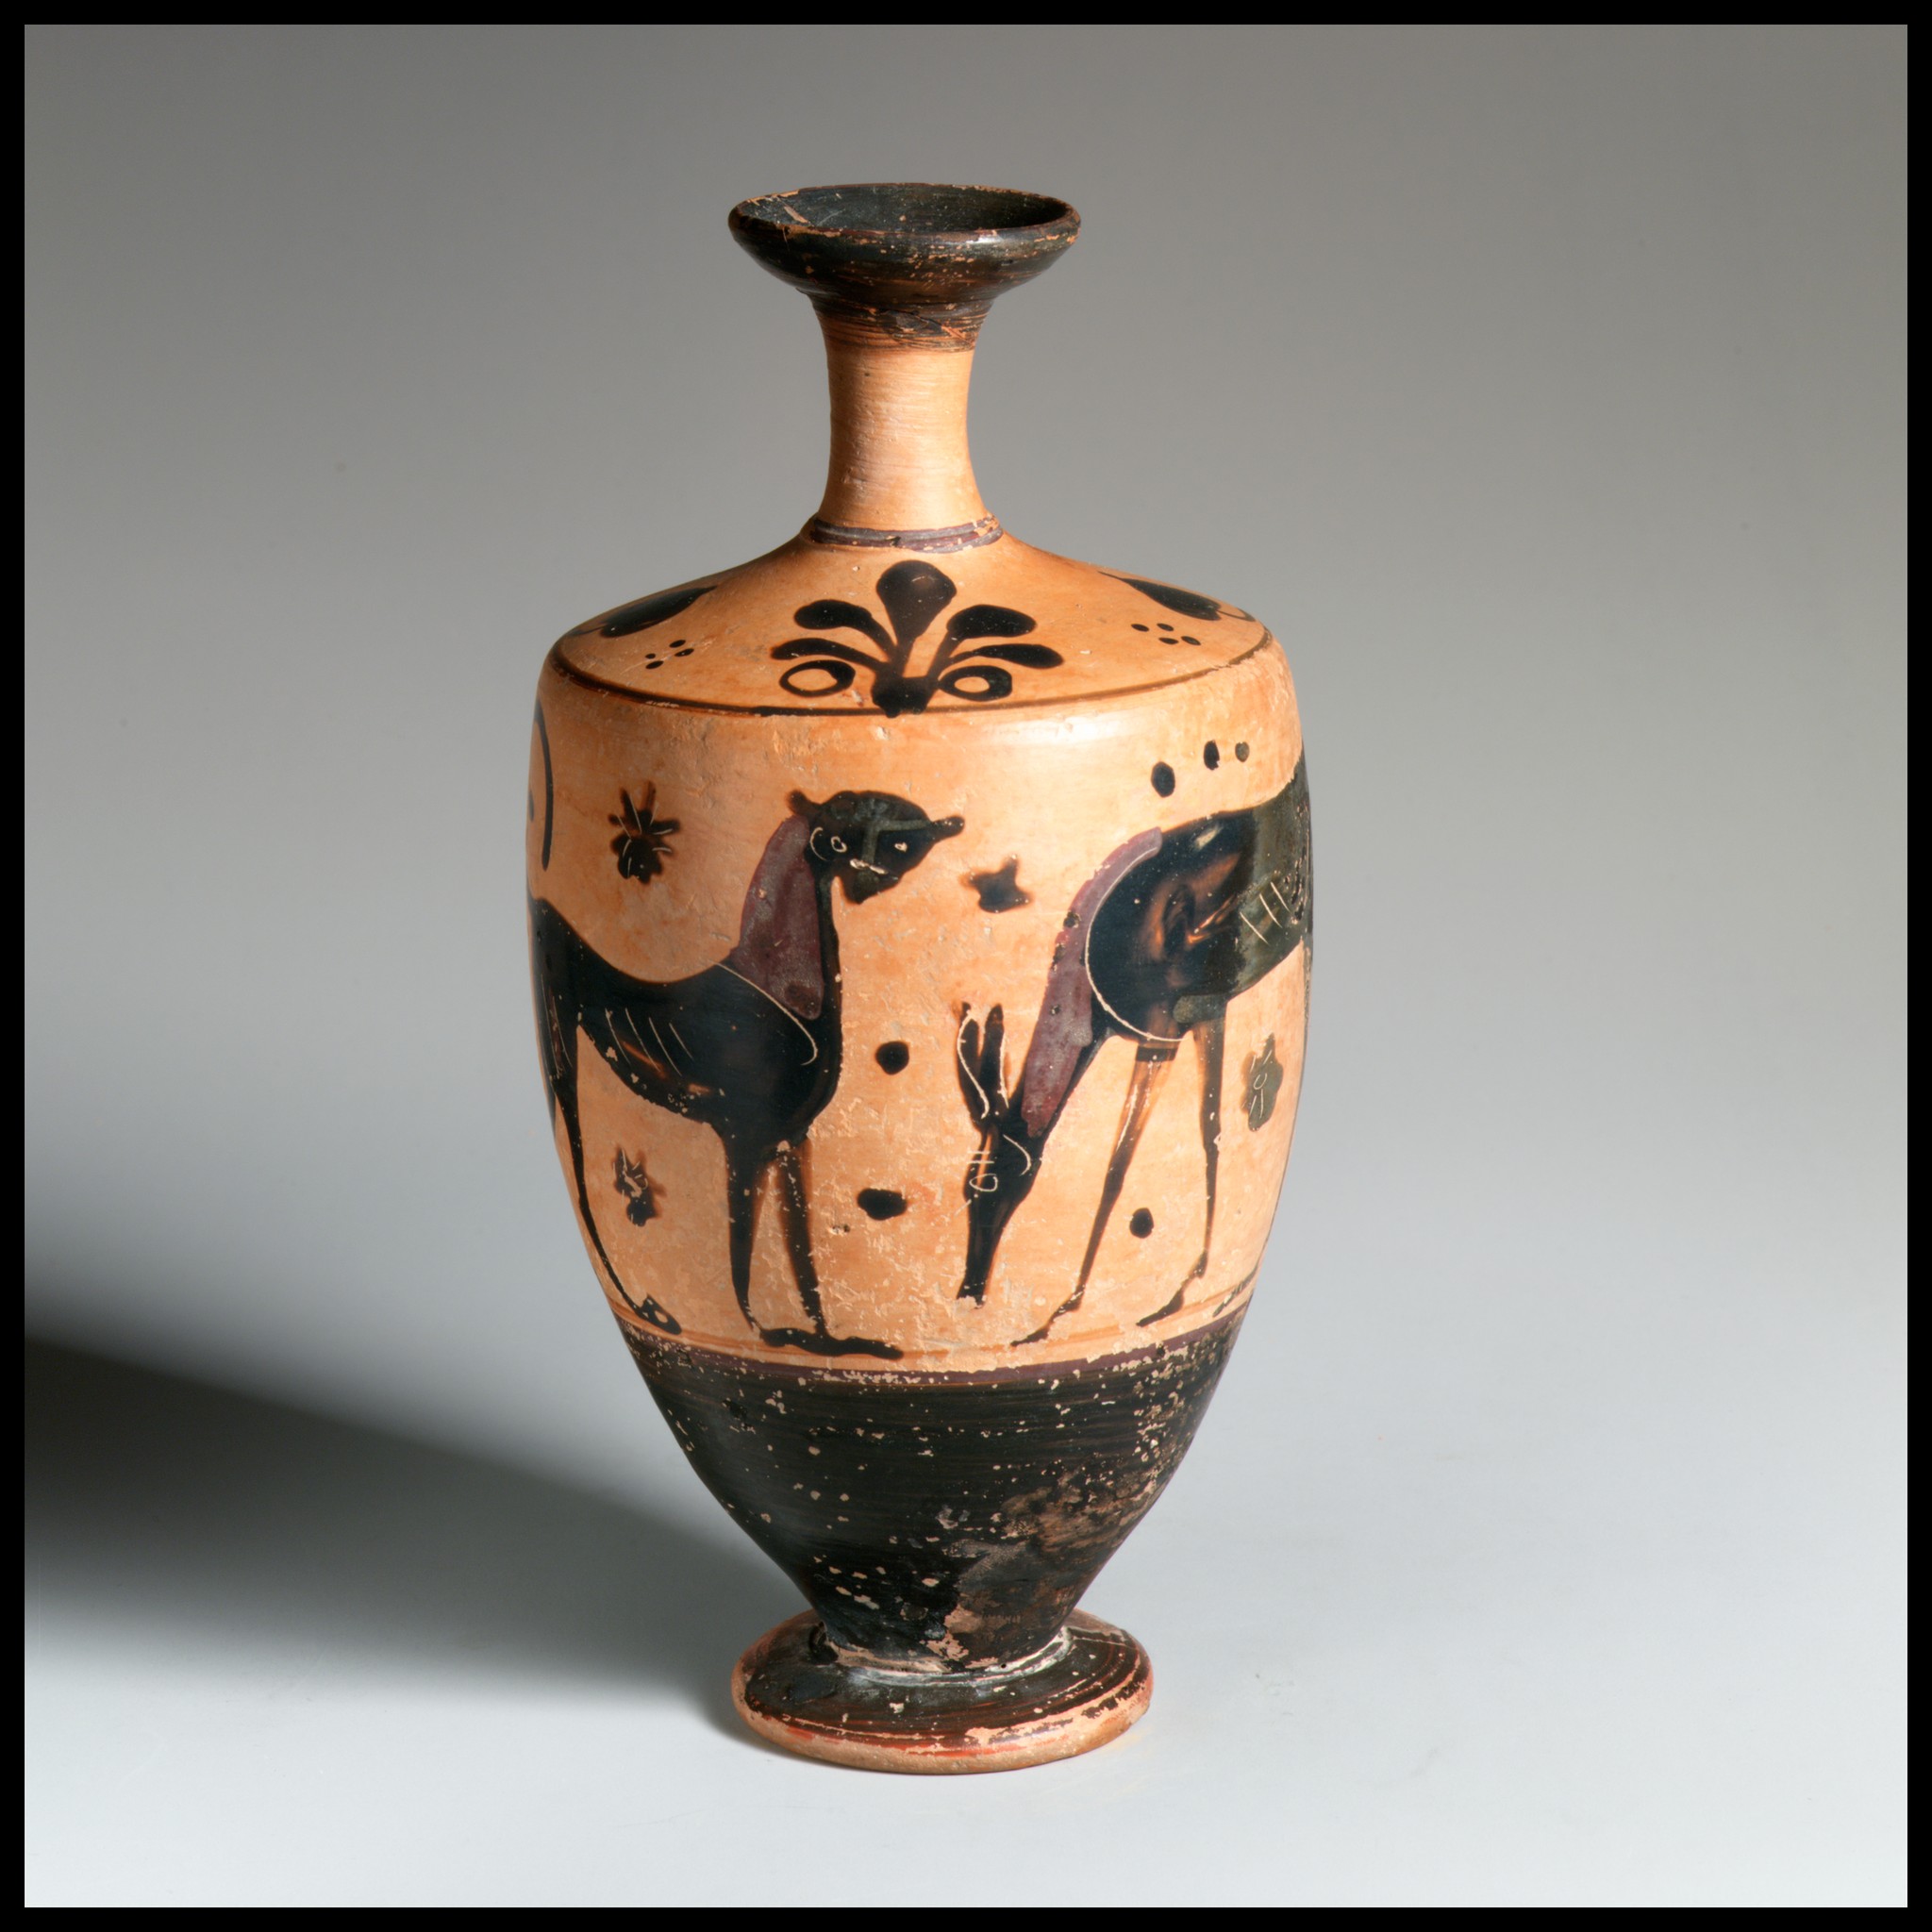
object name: lekythos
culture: greek, attic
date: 560 BCE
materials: terracotta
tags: animals,deer